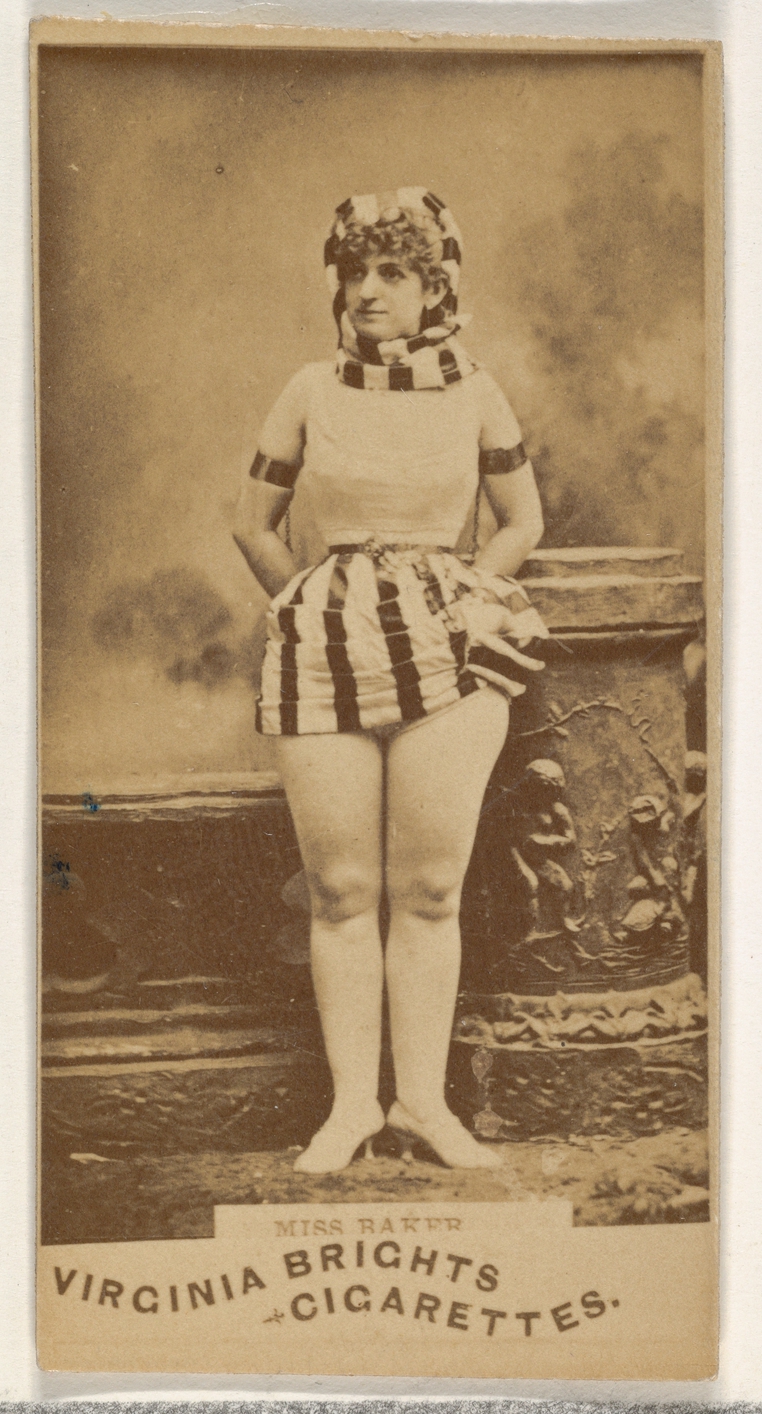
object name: photograph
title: Miss Baker, from the Actors and Actresses series (N45, Type 1) for Virginia Brights Cigarettes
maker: allen & ginter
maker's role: publisher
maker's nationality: american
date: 1888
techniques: albumen silver print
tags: portraits,women,actresses